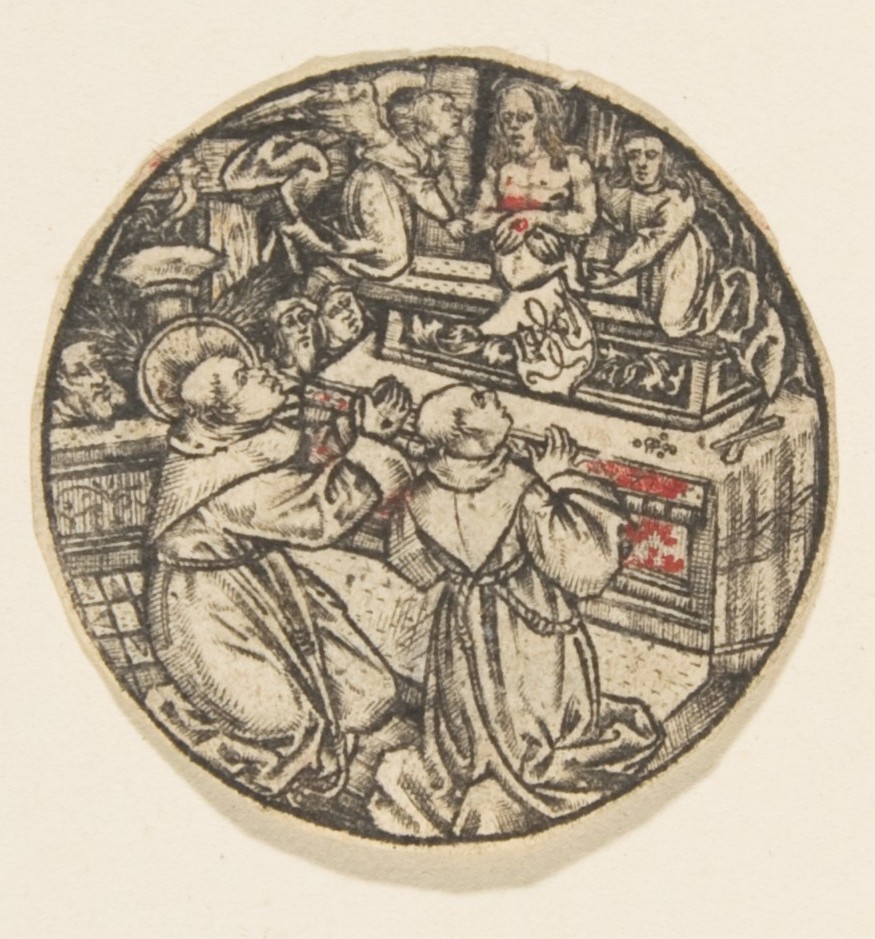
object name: print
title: The Mass of St. Gregory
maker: anonymous, german, 15th century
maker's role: artist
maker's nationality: german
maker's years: 1400-1500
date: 1401-1500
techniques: woodcut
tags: angels,saints